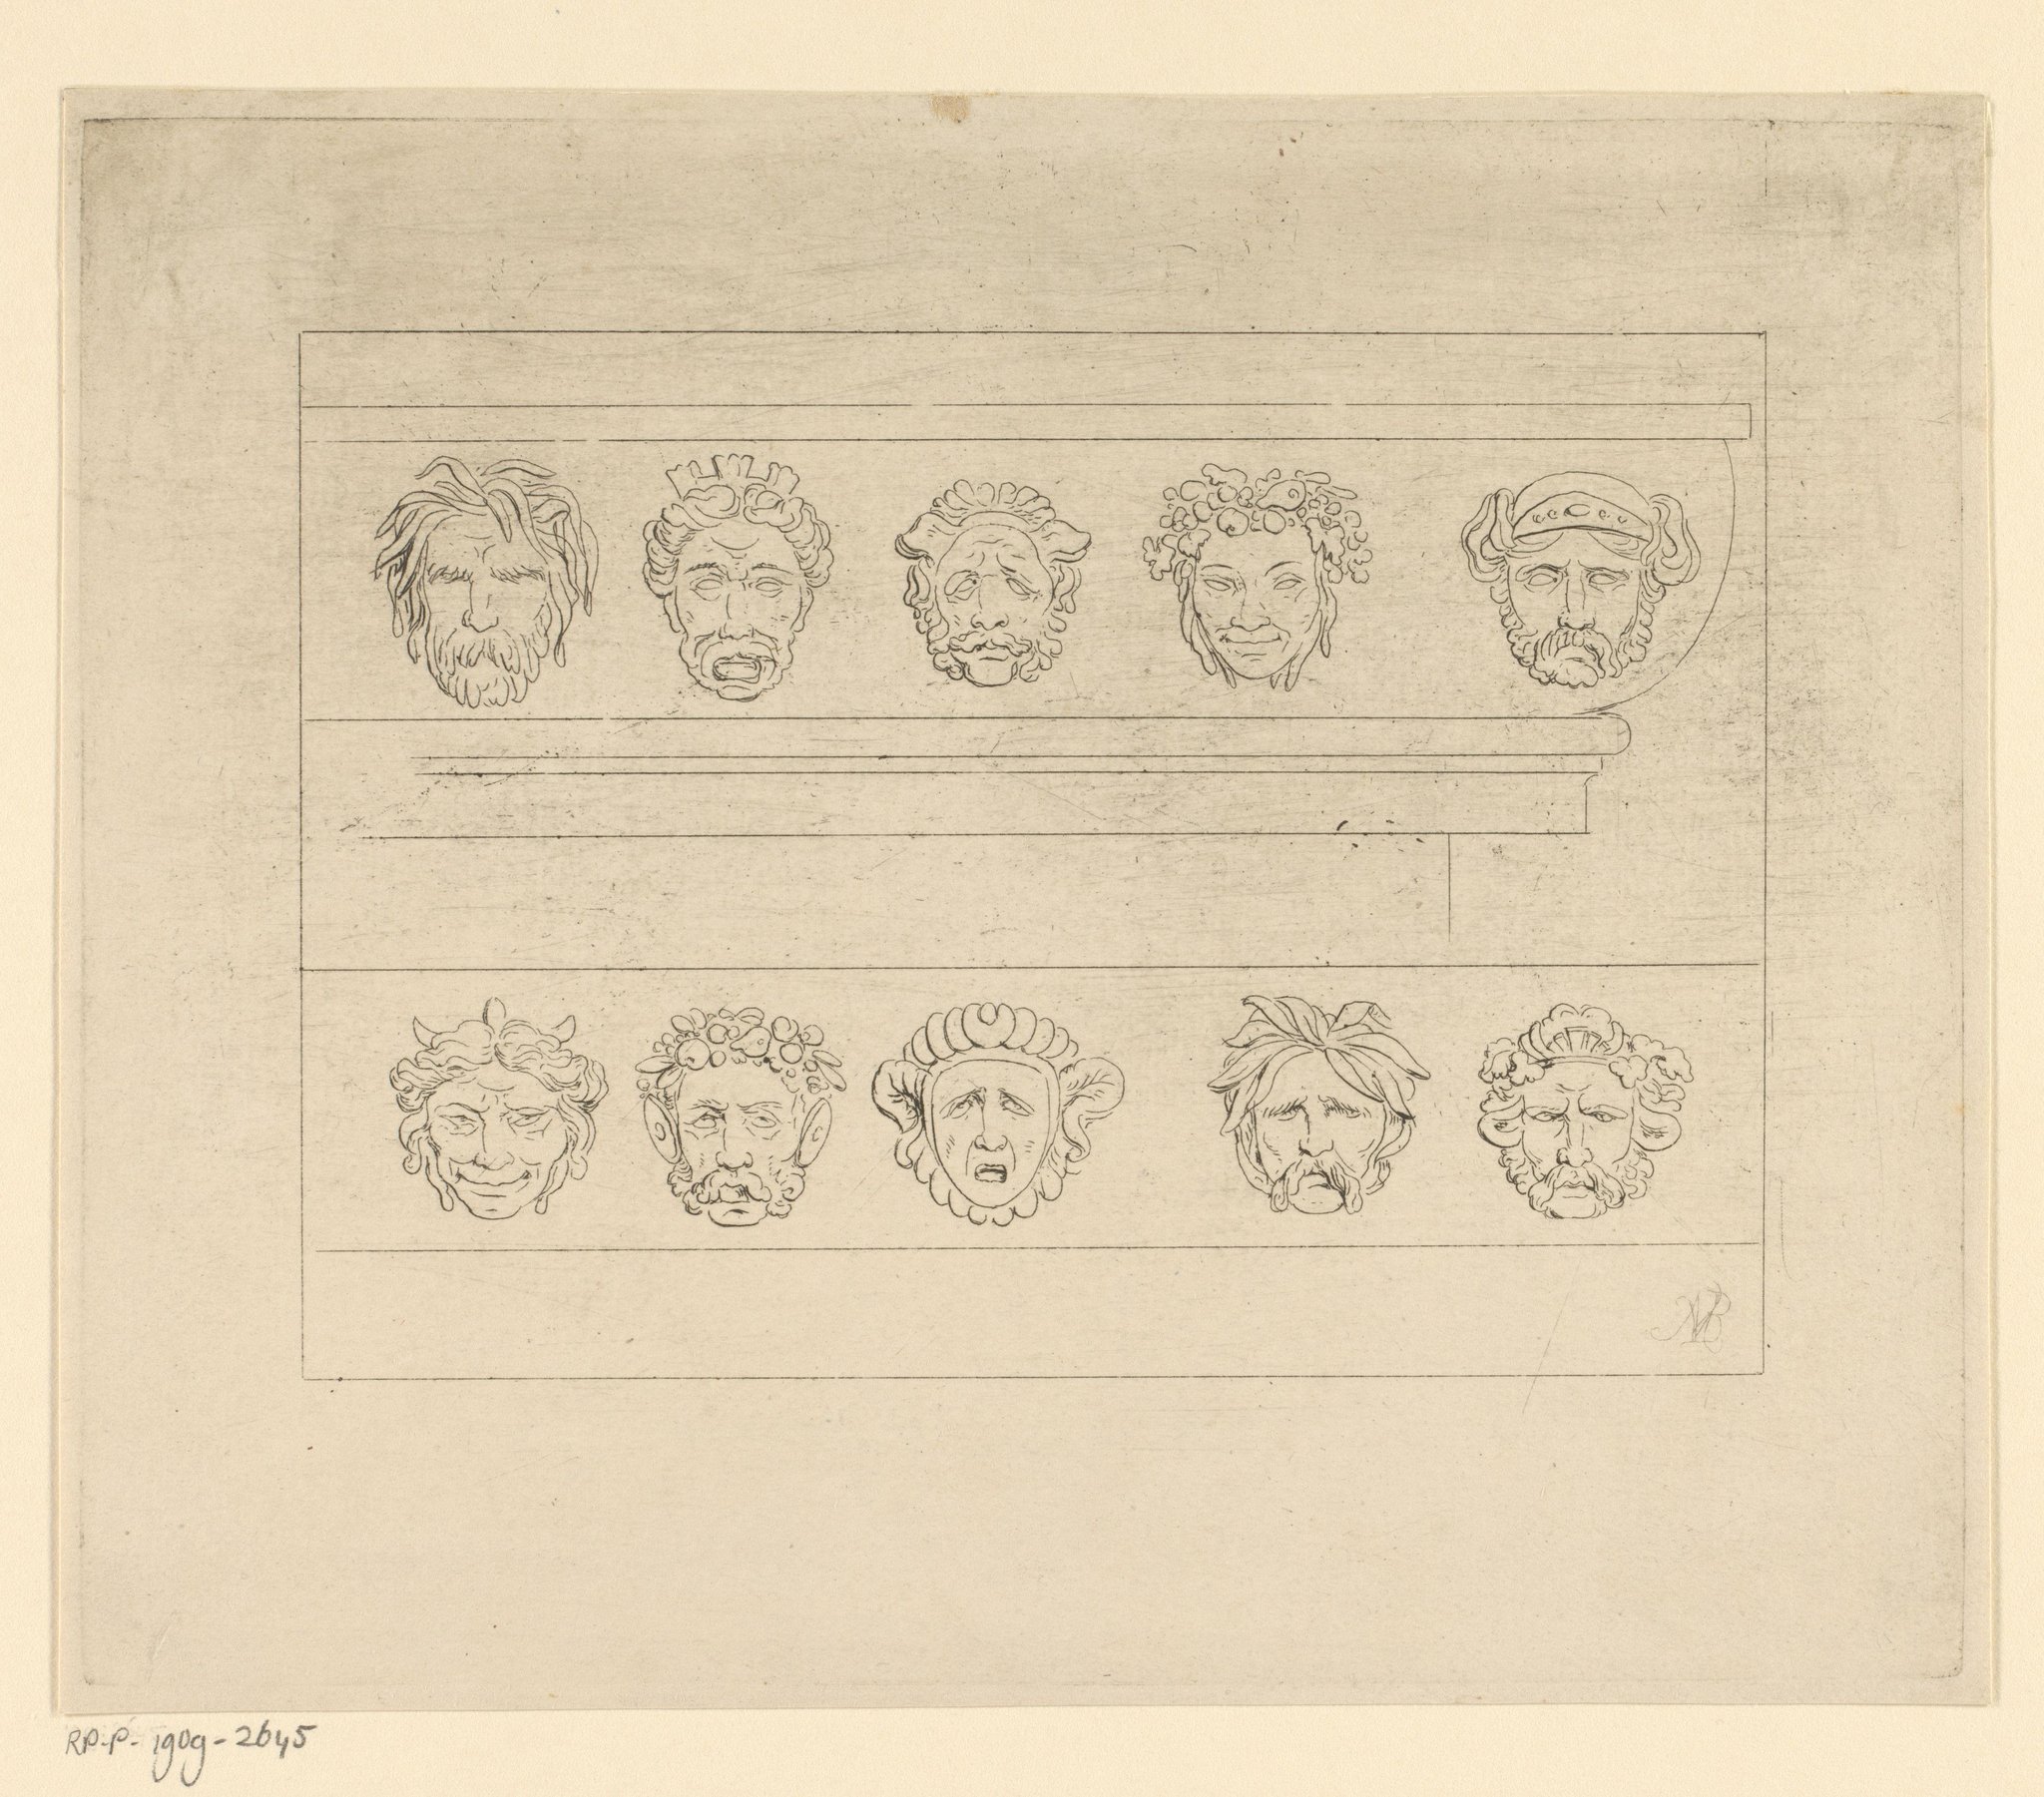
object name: print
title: Tien maskers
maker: mattheus ignatius van bree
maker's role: draughtsman, print maker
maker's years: 1773-1839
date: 1783-1839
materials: paper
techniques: etching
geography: antwerp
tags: mask, mascaron ~ ornament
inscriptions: collector's mark: Lugt 2228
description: Boven vijf maskers op een fries. Onder vijf maskers.